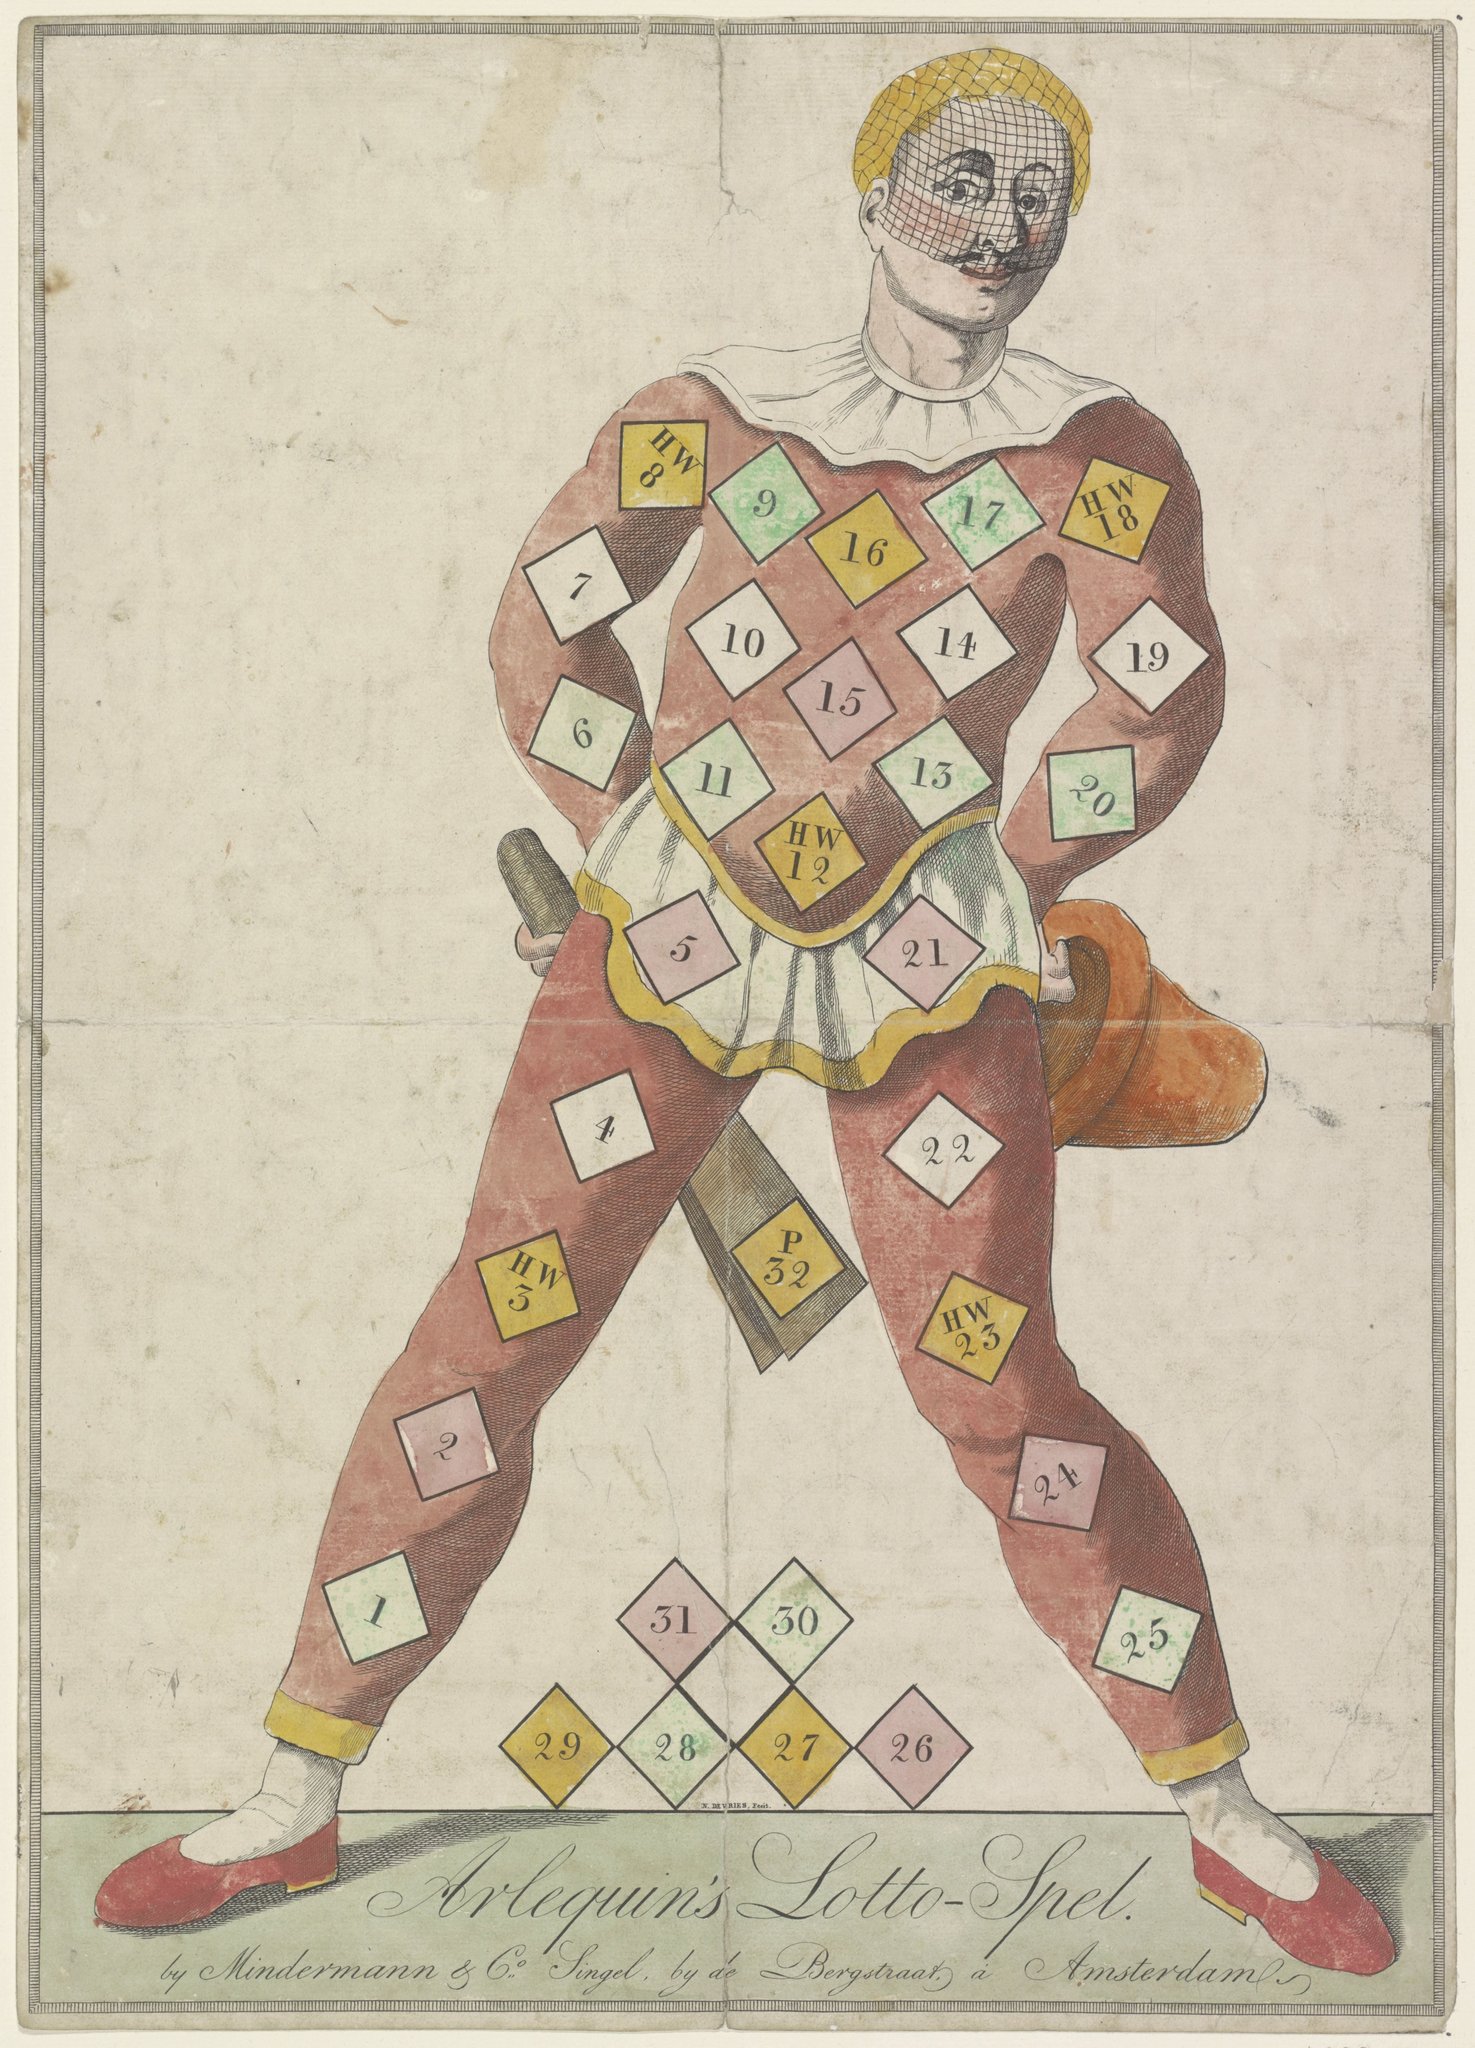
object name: popular print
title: Arlequin's Lotto-spel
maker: n. de vries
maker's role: print maker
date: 1814-1848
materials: paper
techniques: colour, engraving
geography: amsterdam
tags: board-games of chance, types in 'commedia dell'arte': harlequin, board-games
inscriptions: collector's mark: Lugt 2760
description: Bordspel in de vorm van een groot Harlekijnfiguur met gespreide benen. Over zijn lichaam en tussen zijn benen vierkante vakjes genummerd van 1 tot en met 32.